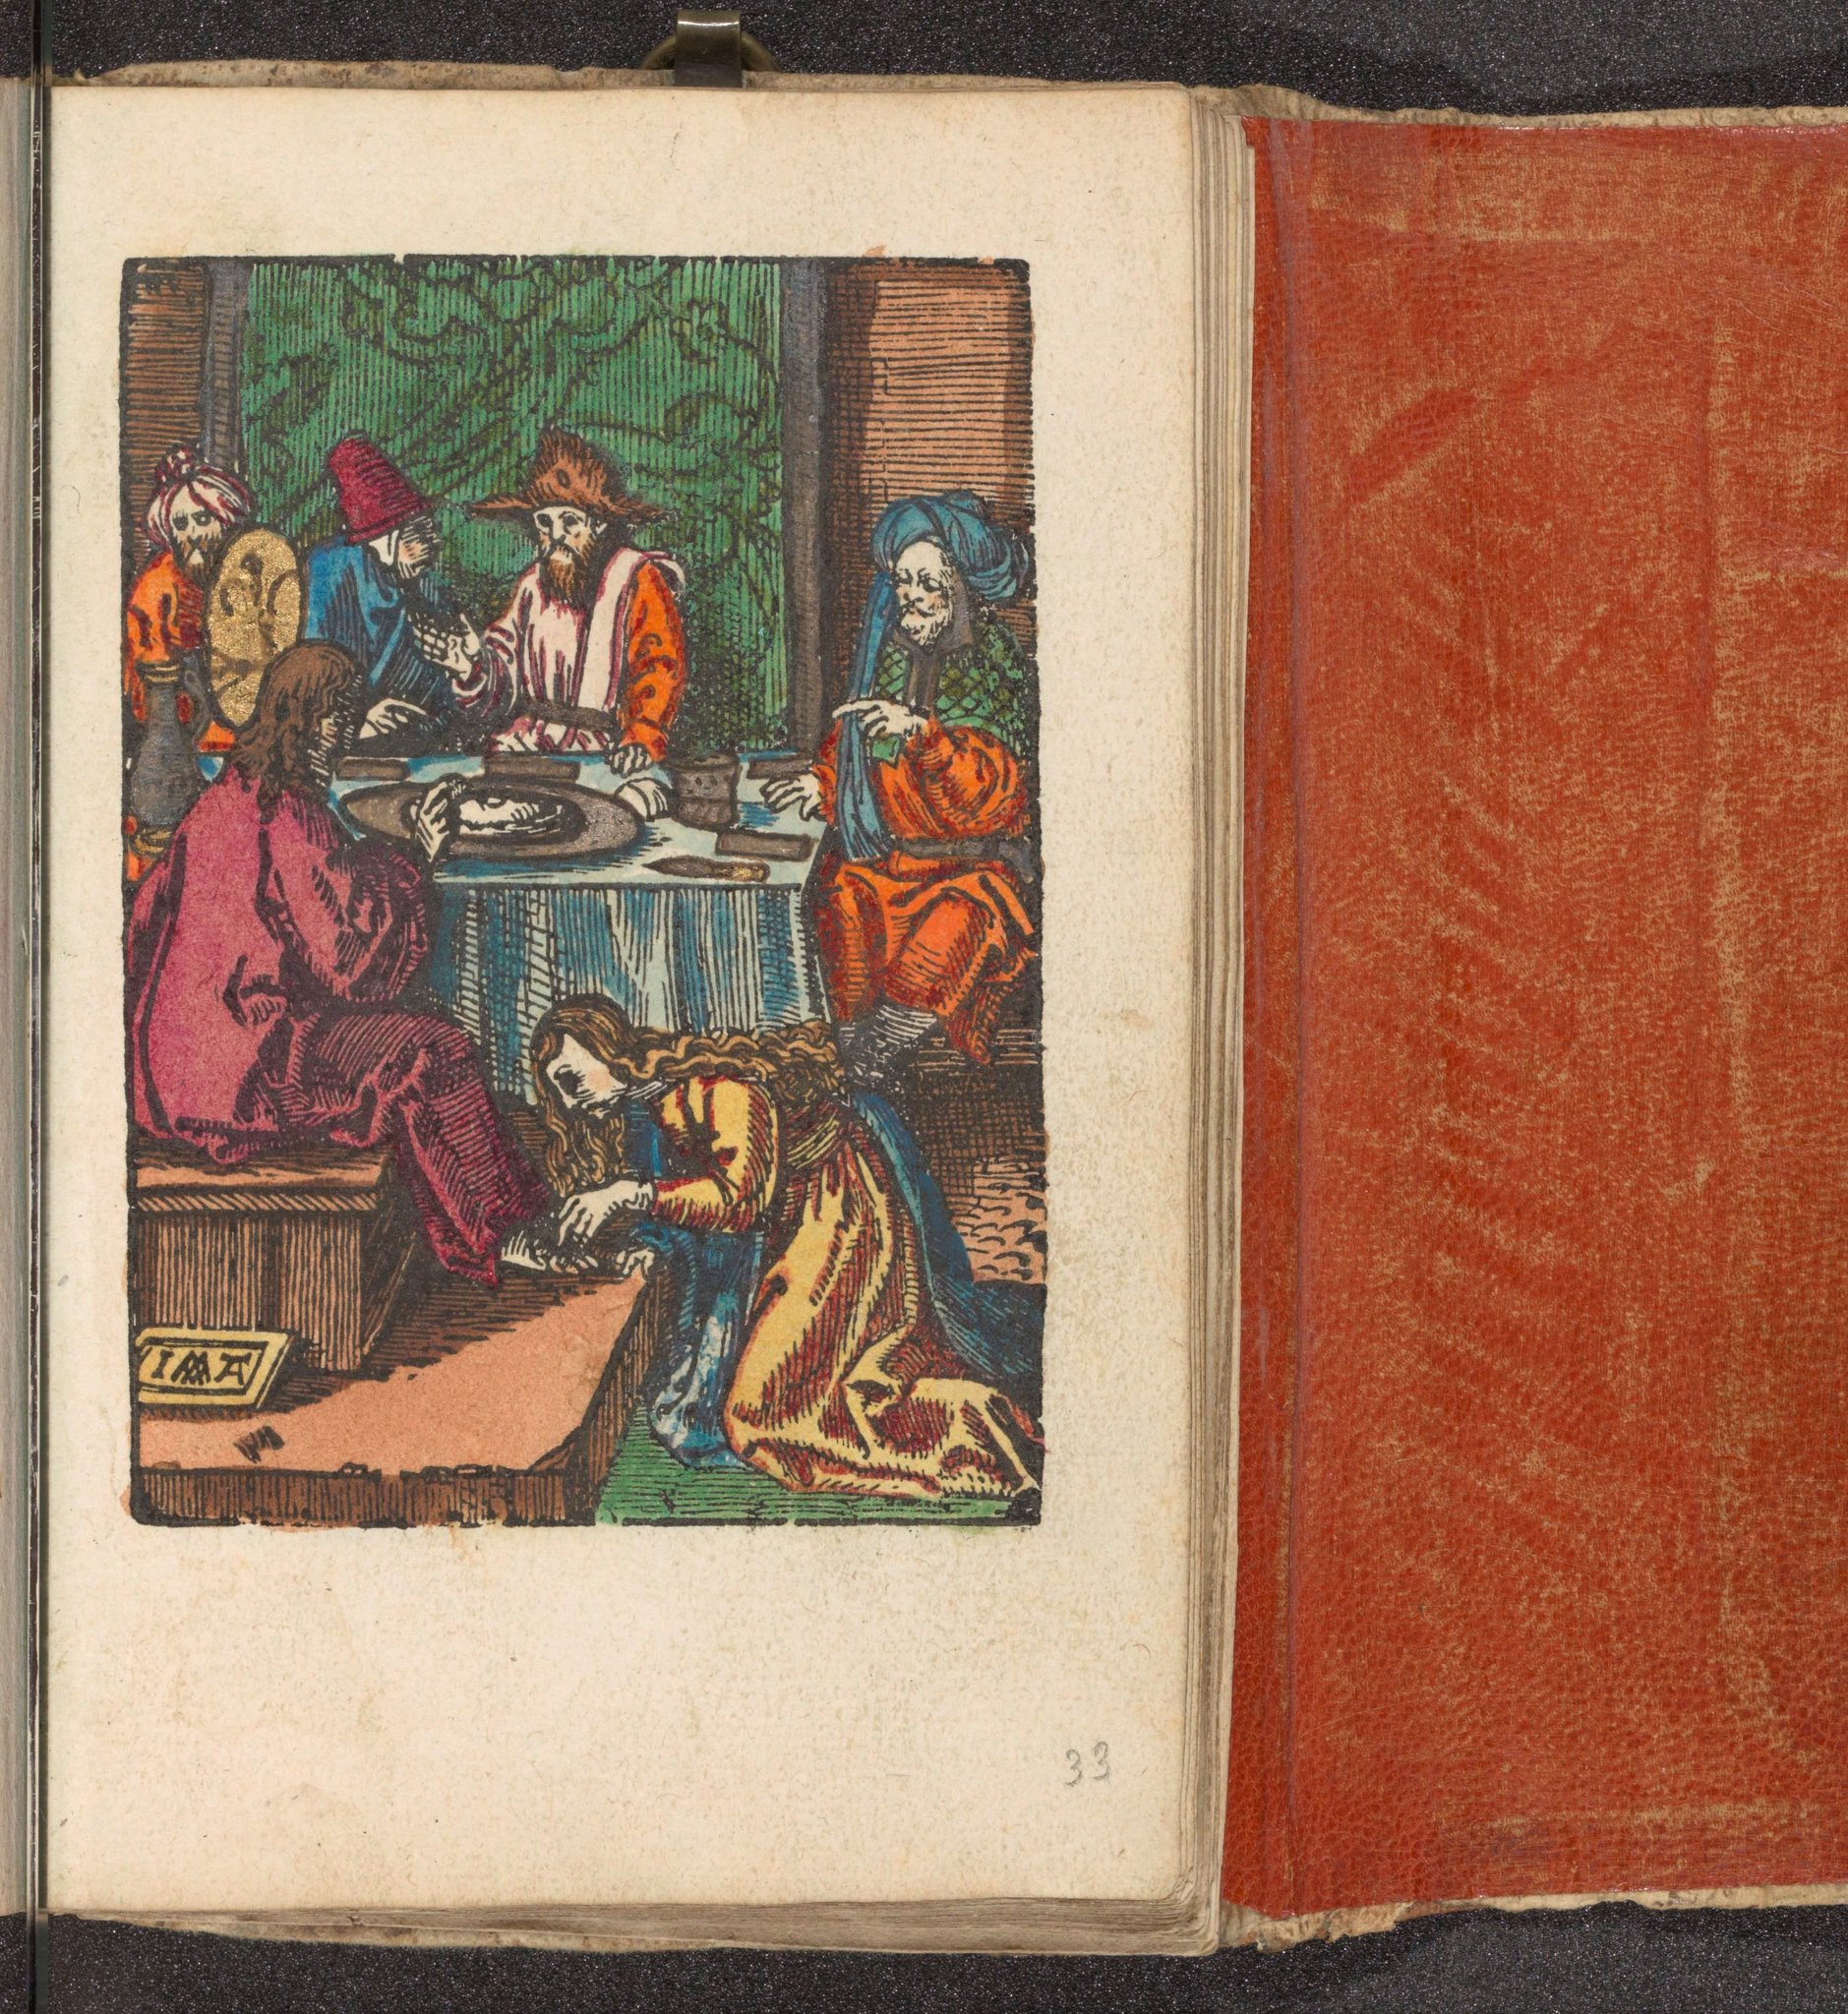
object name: print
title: Stomme Passie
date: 1520-1521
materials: paper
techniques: hand coloring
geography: amsterdam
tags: book in which illustrations are essential, meal at the house of simon the pharisee (luke 7:36-50), a woman washes christ's feet with her tears, and wipes them with her hair, christ's feet are anointed by mary (magdalene), meal in bethany (at the house of simon the leper) (matthew 26:6-13; mark 14:3-9; john 12:1-11)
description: Christus zit aan tafel te eten in het huis van Simon de Farizeeër. Maria Magdalena knielt op de grond zalft zijn voeten en droogt ze met haar haren. Prent maakt deel uit van een boek.